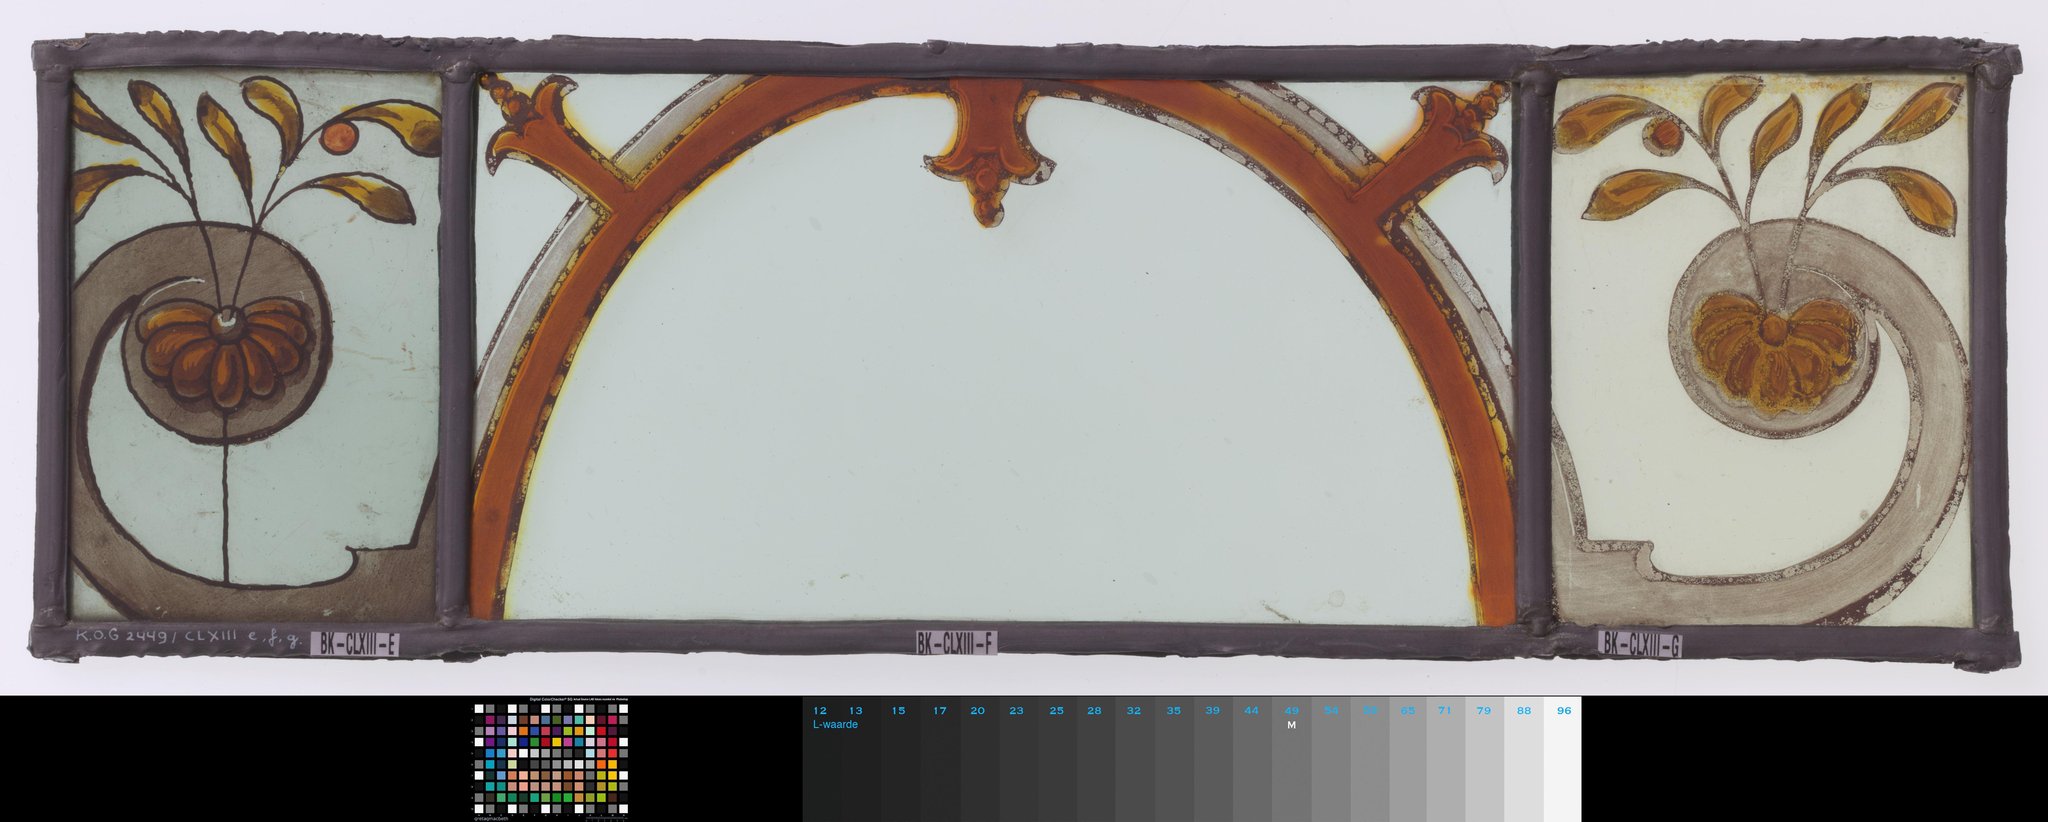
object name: light window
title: Ruit met geometrisch ornament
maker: Anonymous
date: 1600-1700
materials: glass, lead, pigment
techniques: leading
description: Ruitje met een geometrisch ornament in bruin en (oranje) geel. Opmerkingen: Onderdeel van de groep BK-CLXIII-a t/m r. Het fragment vormt één geheel met BK-CLXIII-e en f.